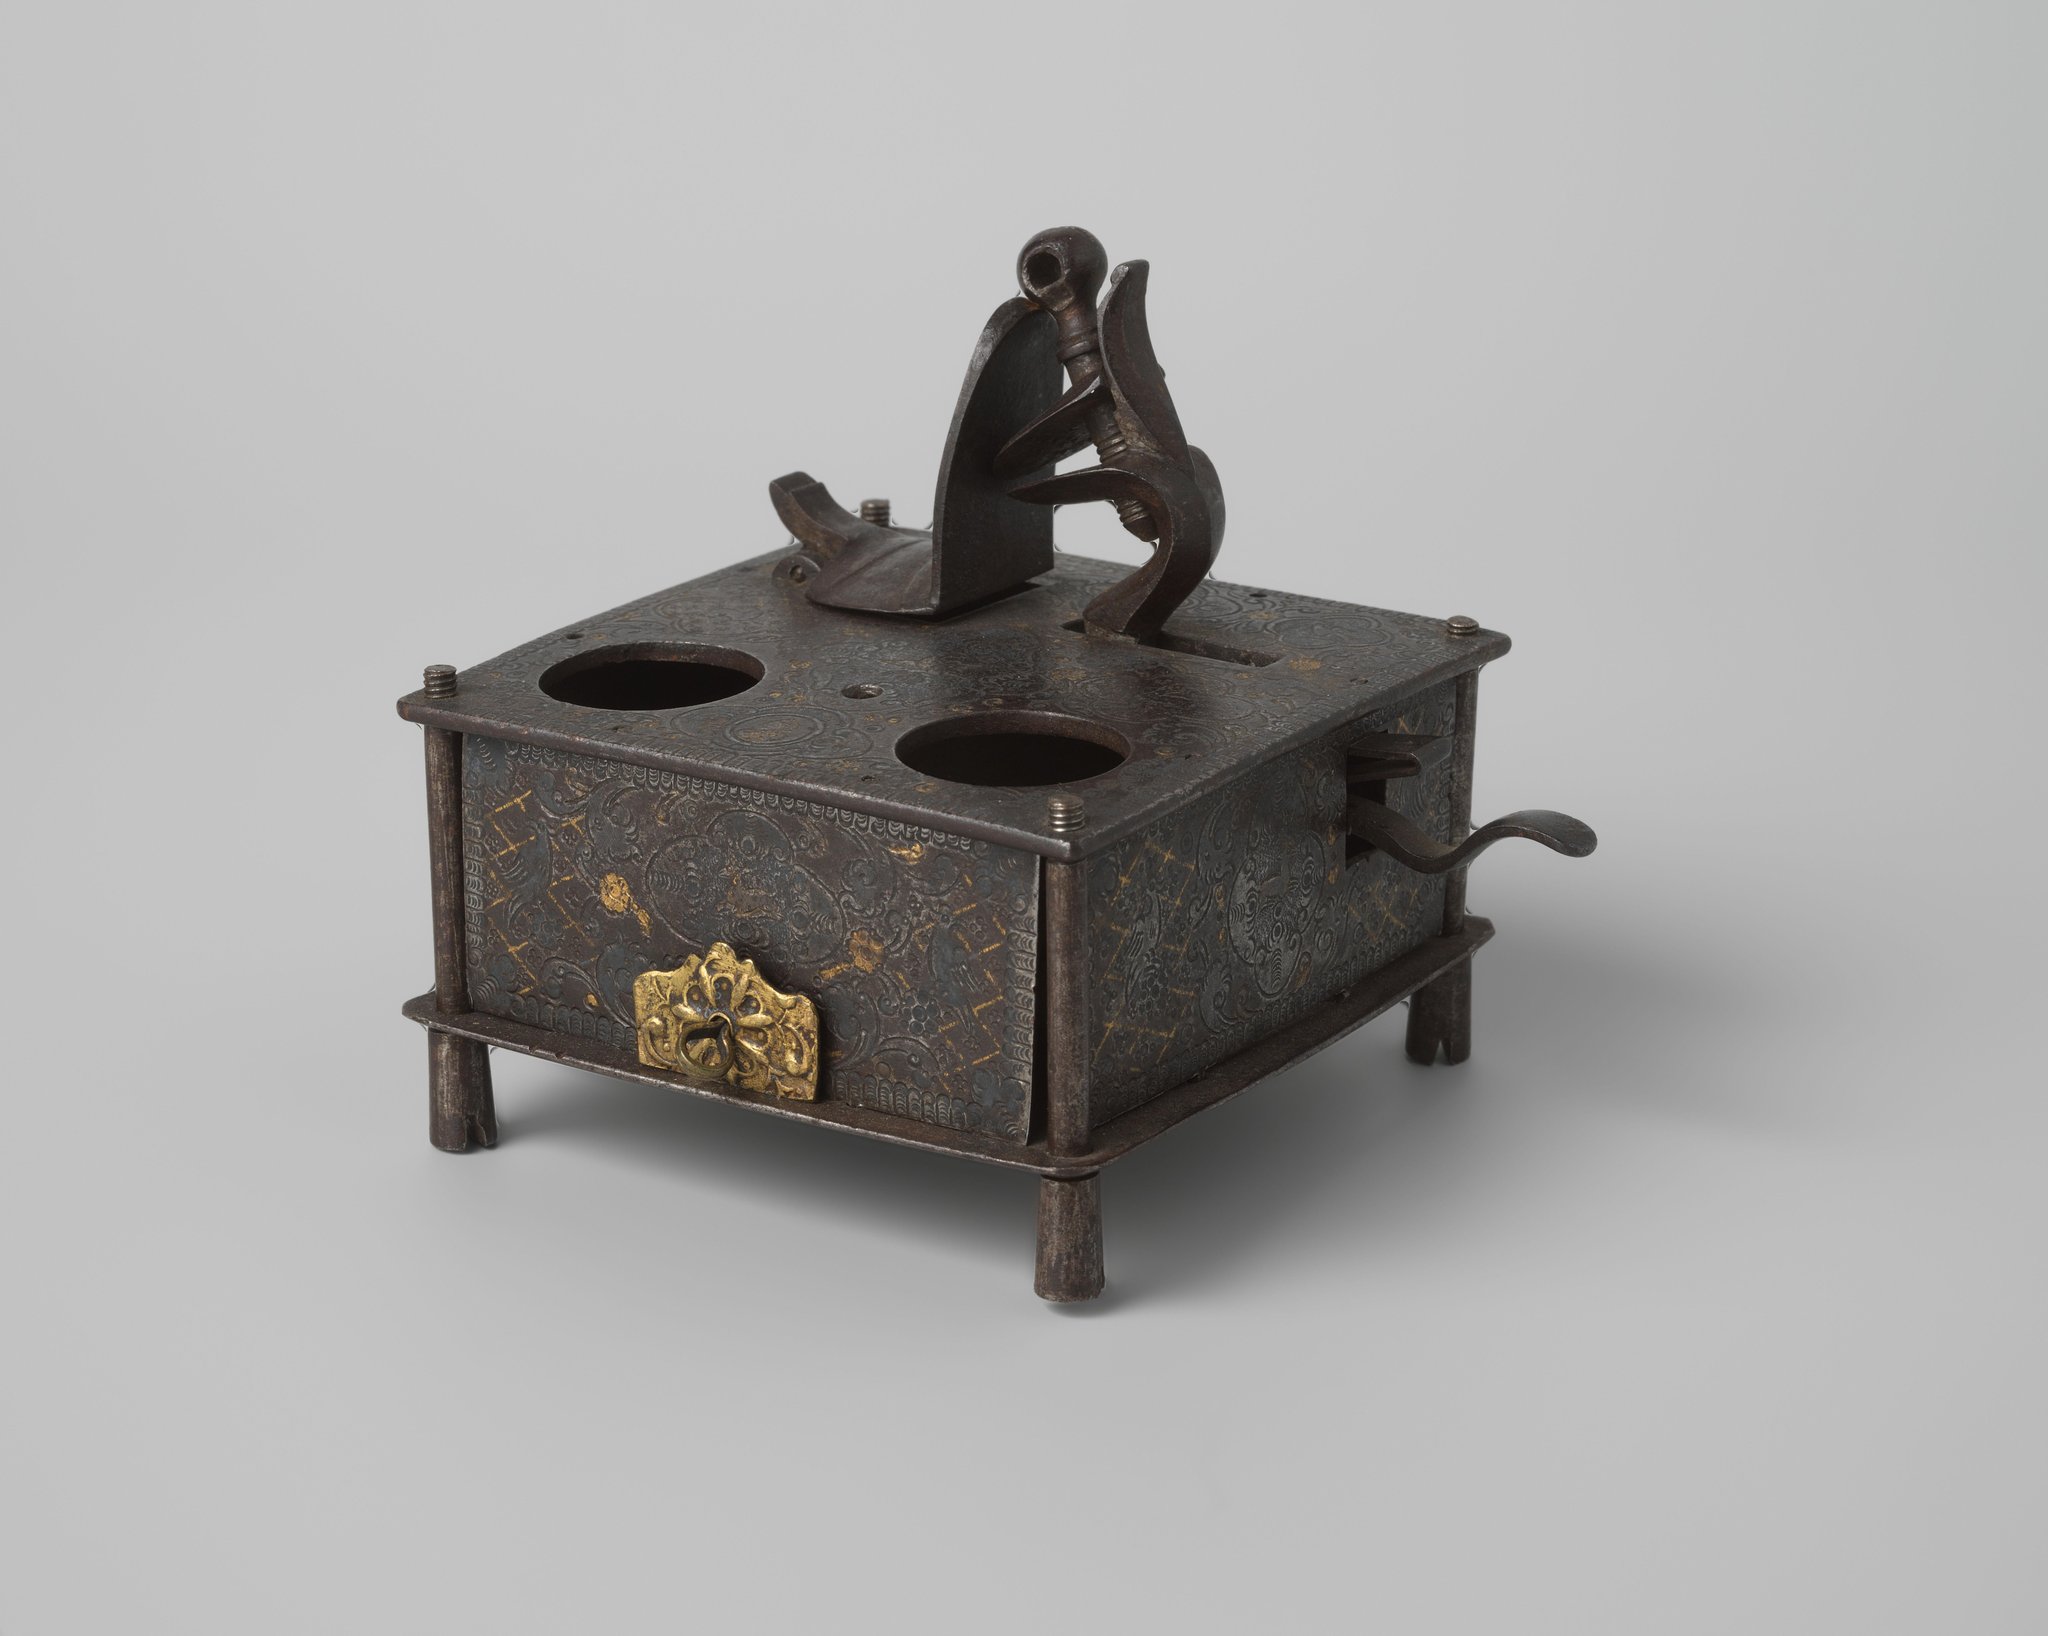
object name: firesteel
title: IJzeren vuurslag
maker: Anonymous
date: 1710-1770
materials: iron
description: Een ijzeren vuurslag. Op vier poten rust een vierkante bak, bestaande uit een horizontale onderplaat, vier ijzeren wanden met damasceer werk in Regencestijl, en een bovenplaat met over een kantige versiering, die voorzien is van twee cirkelvormige en een rechthoekig opening en een veer; de rechthoekige opening kan gesloten worden door een plaat, die voorzien is van een verticaal veilingstuk. In een de wanden is een opening voor het lade.